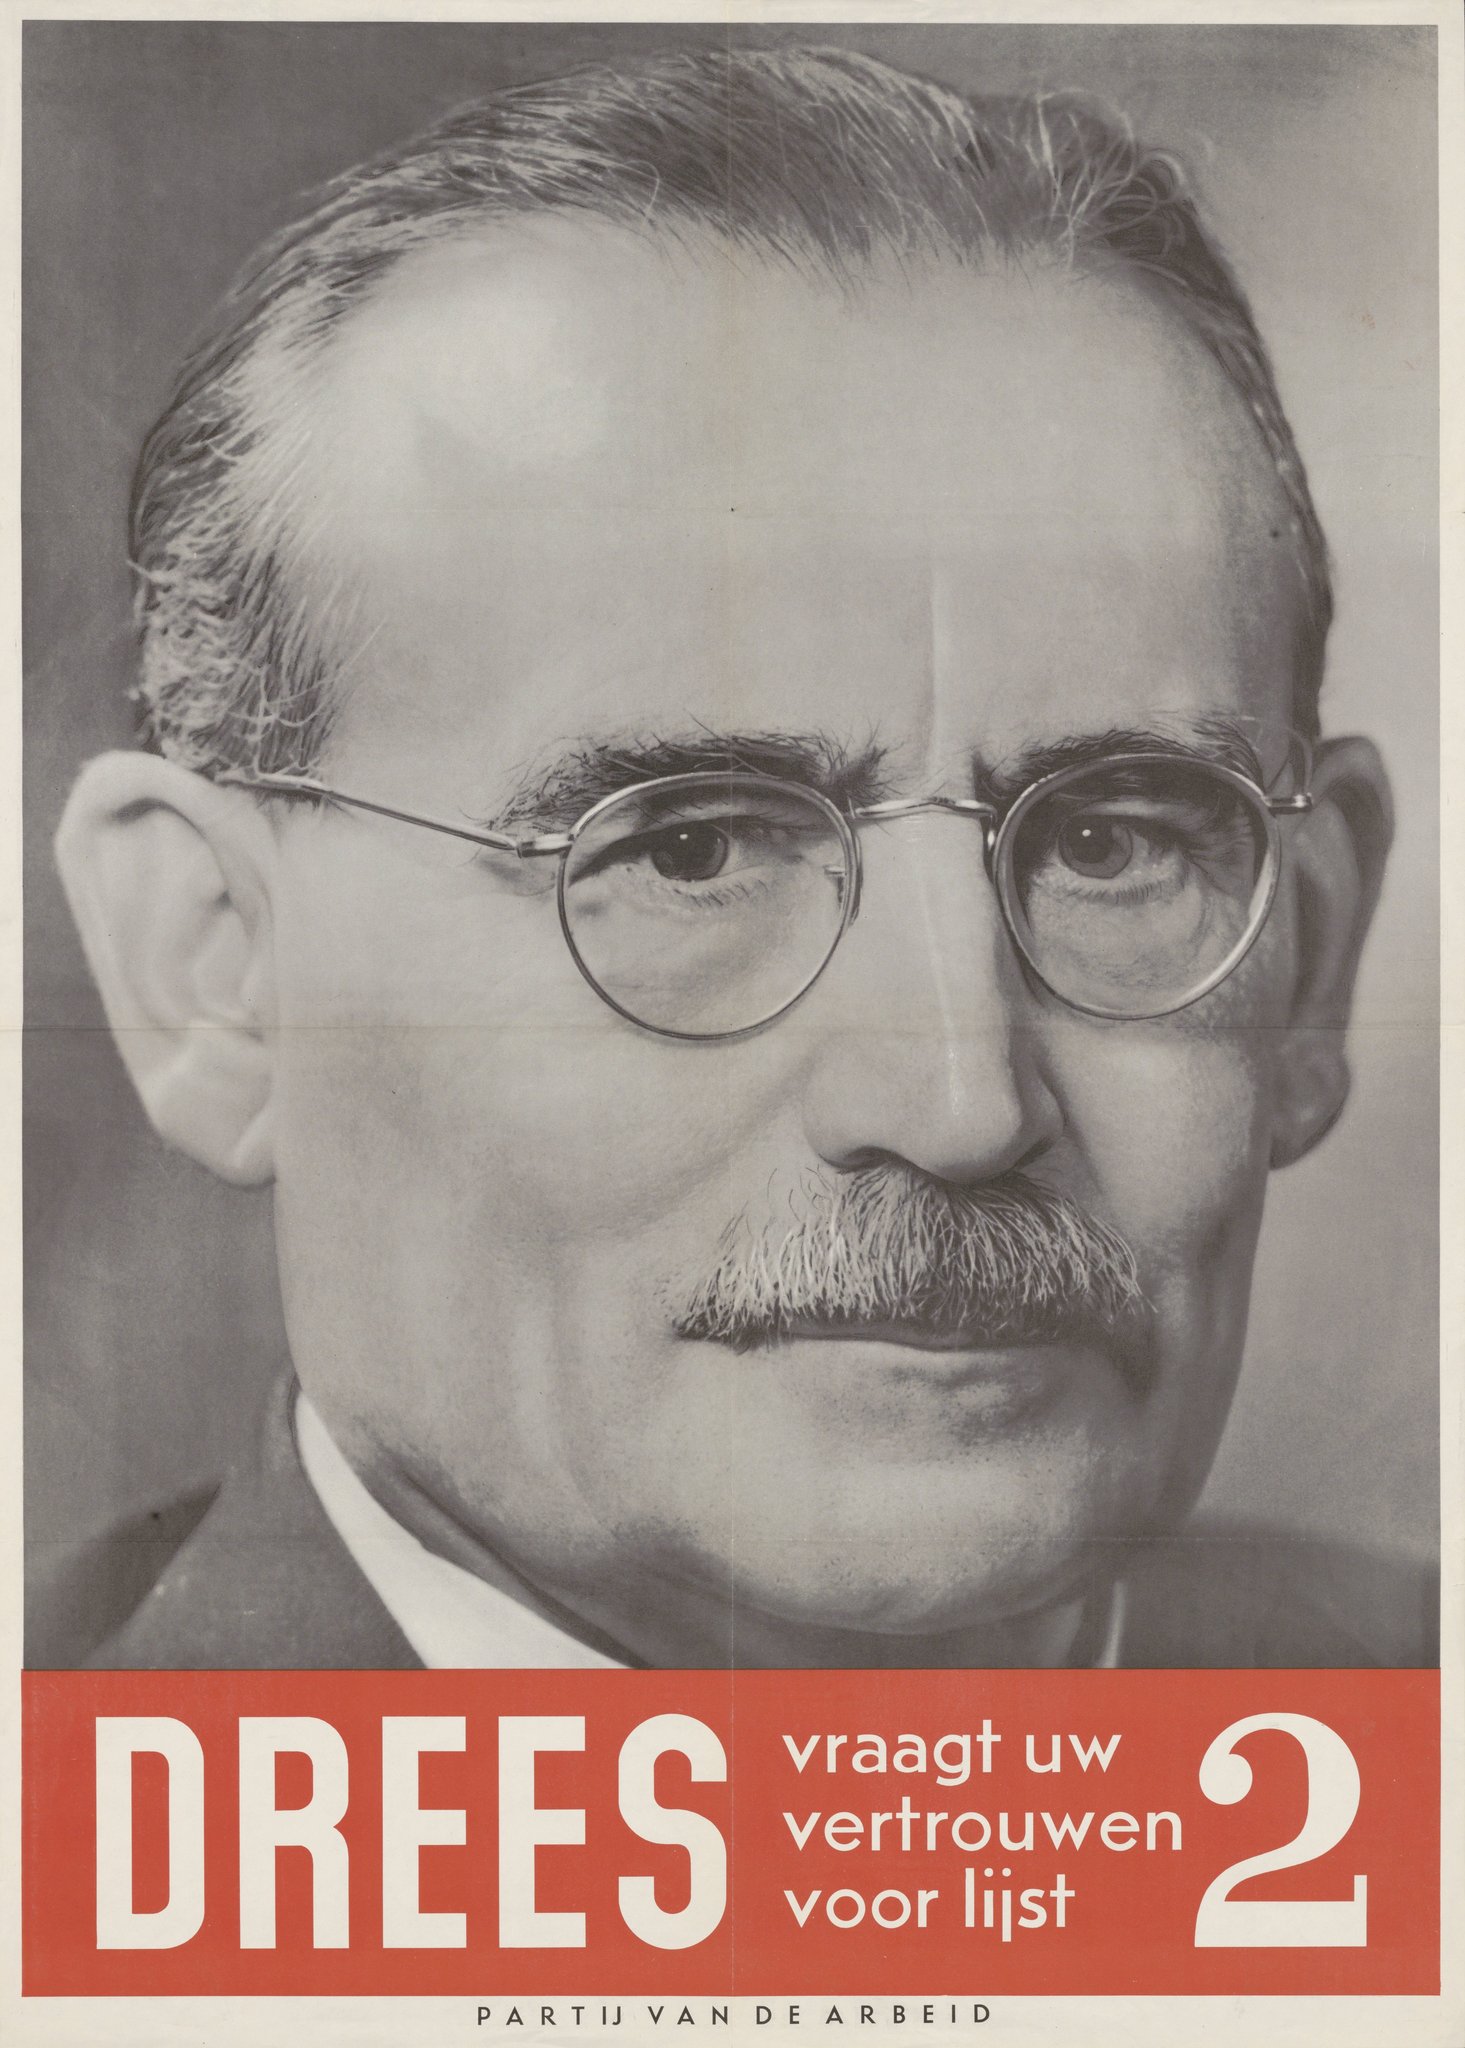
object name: poster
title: Verkiezingsaffiche van de Partij van de Arbeid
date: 1952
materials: paper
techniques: printing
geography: amsterdam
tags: amsterdam, the hague, willem drees, netherlands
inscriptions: inscription: ‘Drees vraagt uw vertrouwen voor lijst 2’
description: Affiche van de Partij van de Arbeid. Grote foto van een man (W. Drees), met daaronder tekst in witte letters op rode achtergrond.